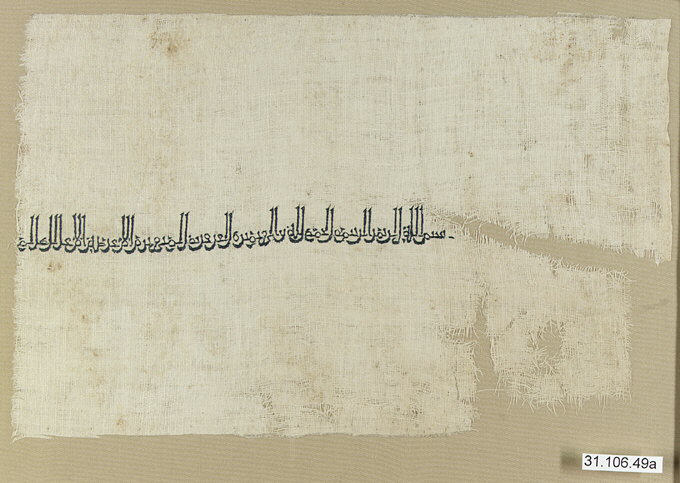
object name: textile fragment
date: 991-1031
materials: linen, silk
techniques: embroidery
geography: egypt